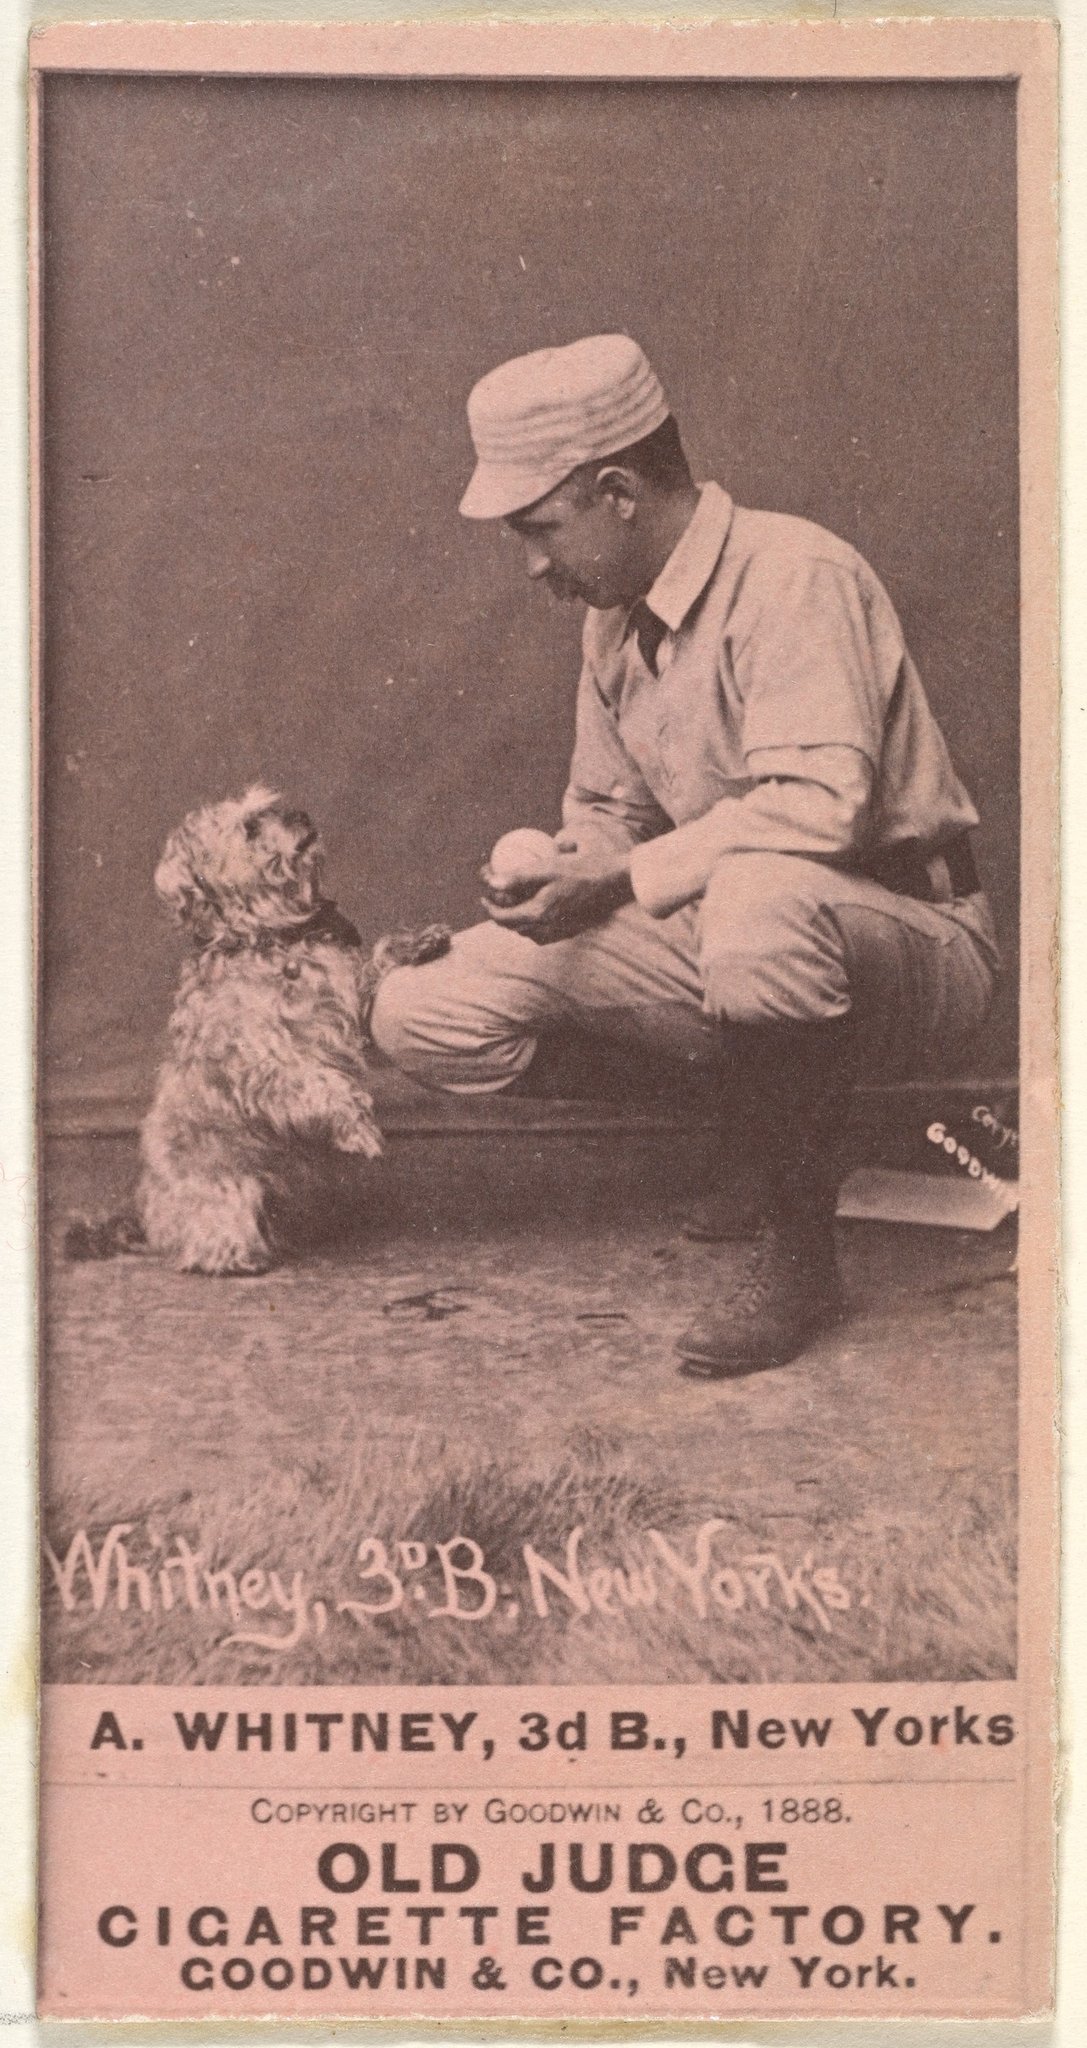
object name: baseball card, photograph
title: Arthur "Art" Wilson Whitney, 3rd Base, New York, from the Old Judge series (N172) for Old Judge Cigarettes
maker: goodwin & company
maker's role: publisher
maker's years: 1850-1950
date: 1888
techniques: albumen silver print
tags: men,baseball,dogs,athletes